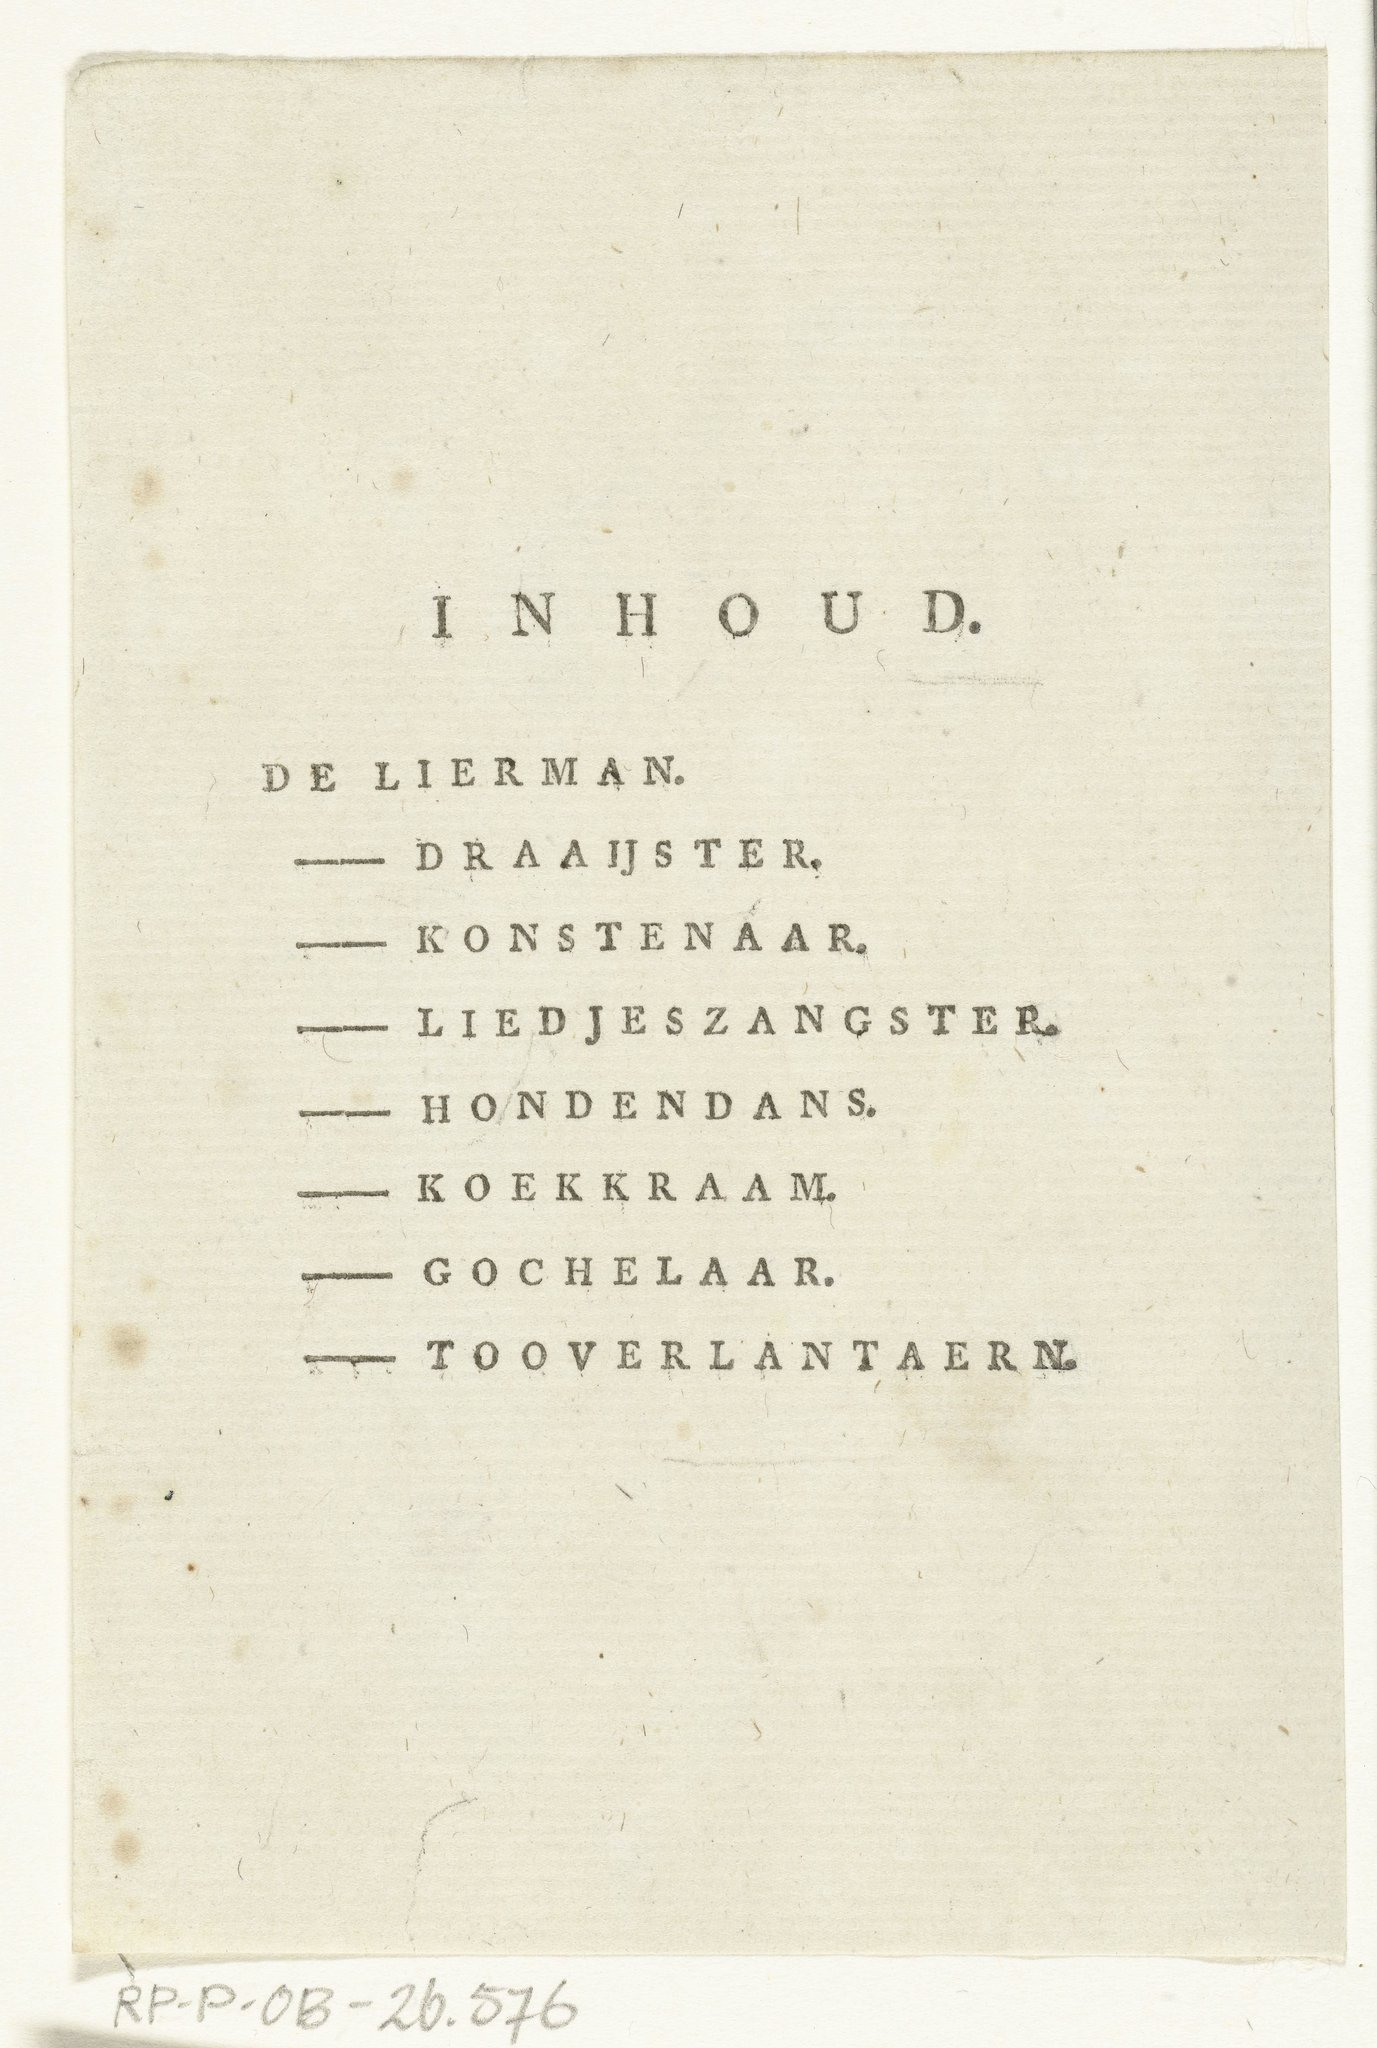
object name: print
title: Inhoudpagina voor: Vaderlandsche Kermisvreugd vertoond in acht kunstplaaten geteekend en gegraveerd door K.F. Bendorp, met toepasselijke Vaersjes door R. Arends, H. de Haas en Compagnie (uitgever) Dordrecht 1782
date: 1782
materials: paper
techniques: letterpress printing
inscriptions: collector's mark: Lugt 2760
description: Inhoudpagina voor: Vaderlandsche Kermisvreugd vertoond in acht kunstplaaten geteekend en gegraveerd door K.F. Bendorp, met toepasselijke Vaersjes door R. Arends, H. de Haas en Compagnie (uitgever) Dordrecht 1782